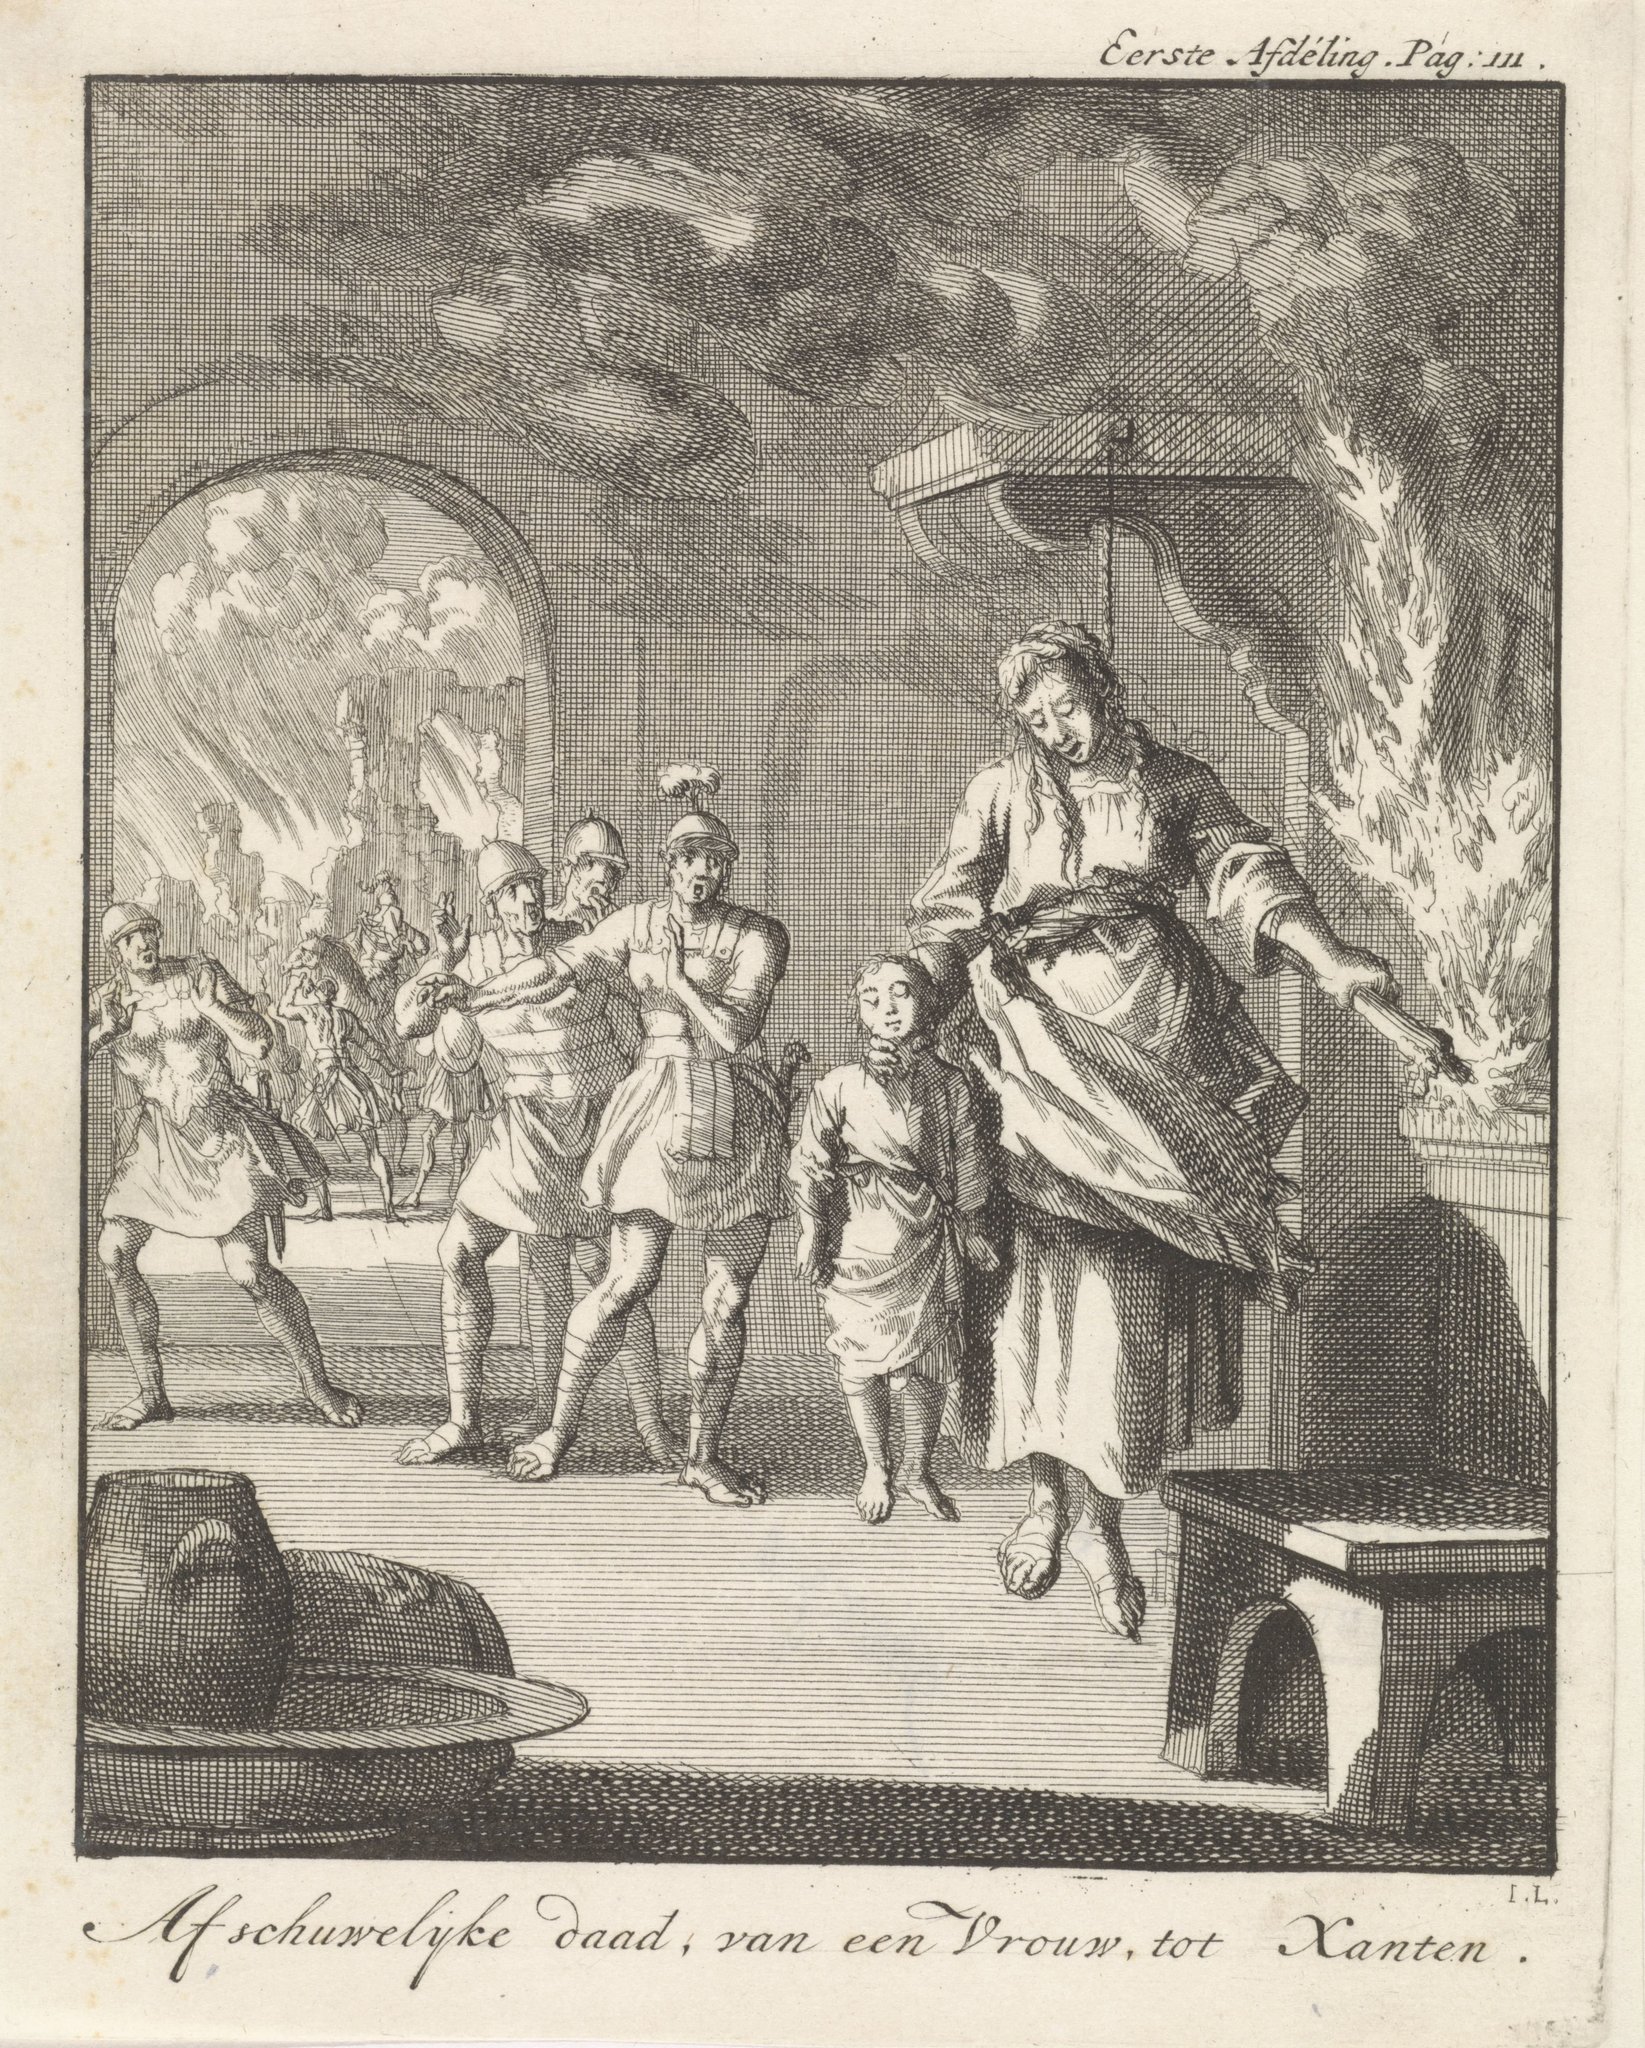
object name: book illustration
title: Afschuwelyke daad, van een Vrouw, tot Xanten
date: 1699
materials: paper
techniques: etching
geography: amsterdam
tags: on fire, ablaze, kitchen, violent death by strangling, suicide out of despair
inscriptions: collector's mark: Lugt 2228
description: Op de voorgrond hangt een vrouw met haar nek aan een touw in een keuken. Ze pleegt zelfmoord. Met haar linkerhand steekt ze met een fakkel het huis in brand. Met haar linkerhand wurgt ze een kind. Op de achtergrond komen Romeinse soldaten binnen.